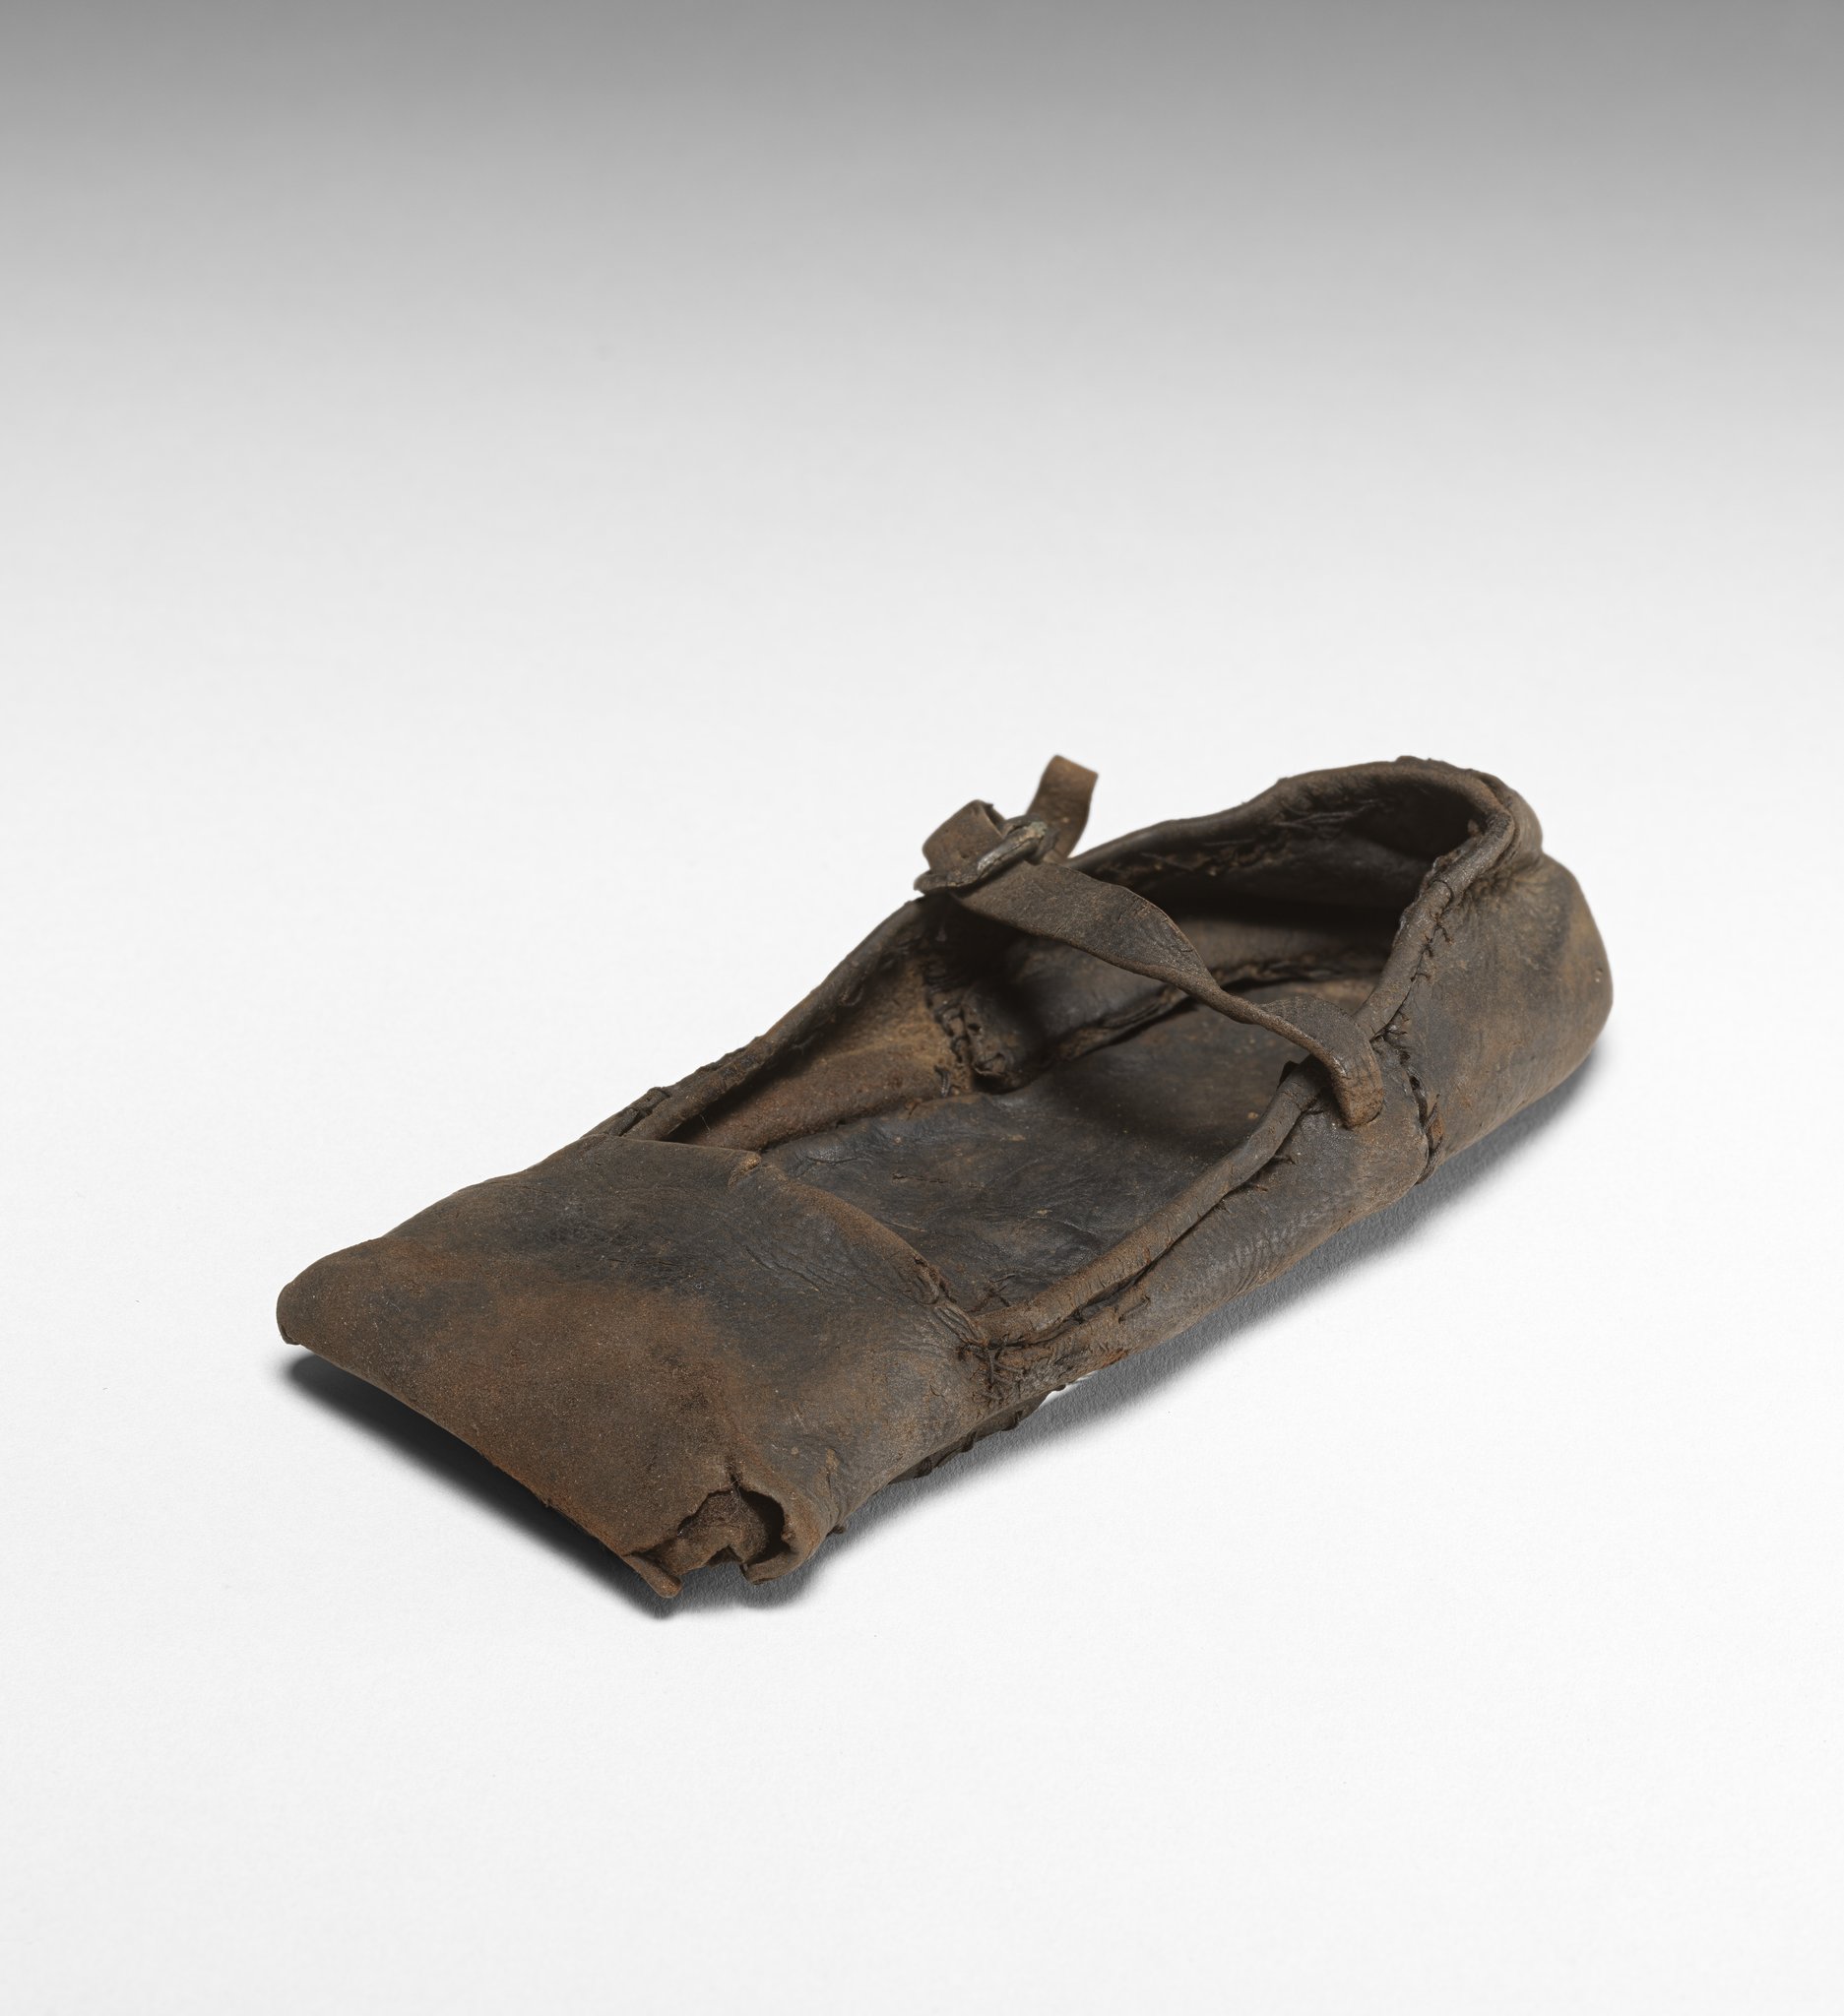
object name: shoe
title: Shoes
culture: british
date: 1501-1600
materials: leather